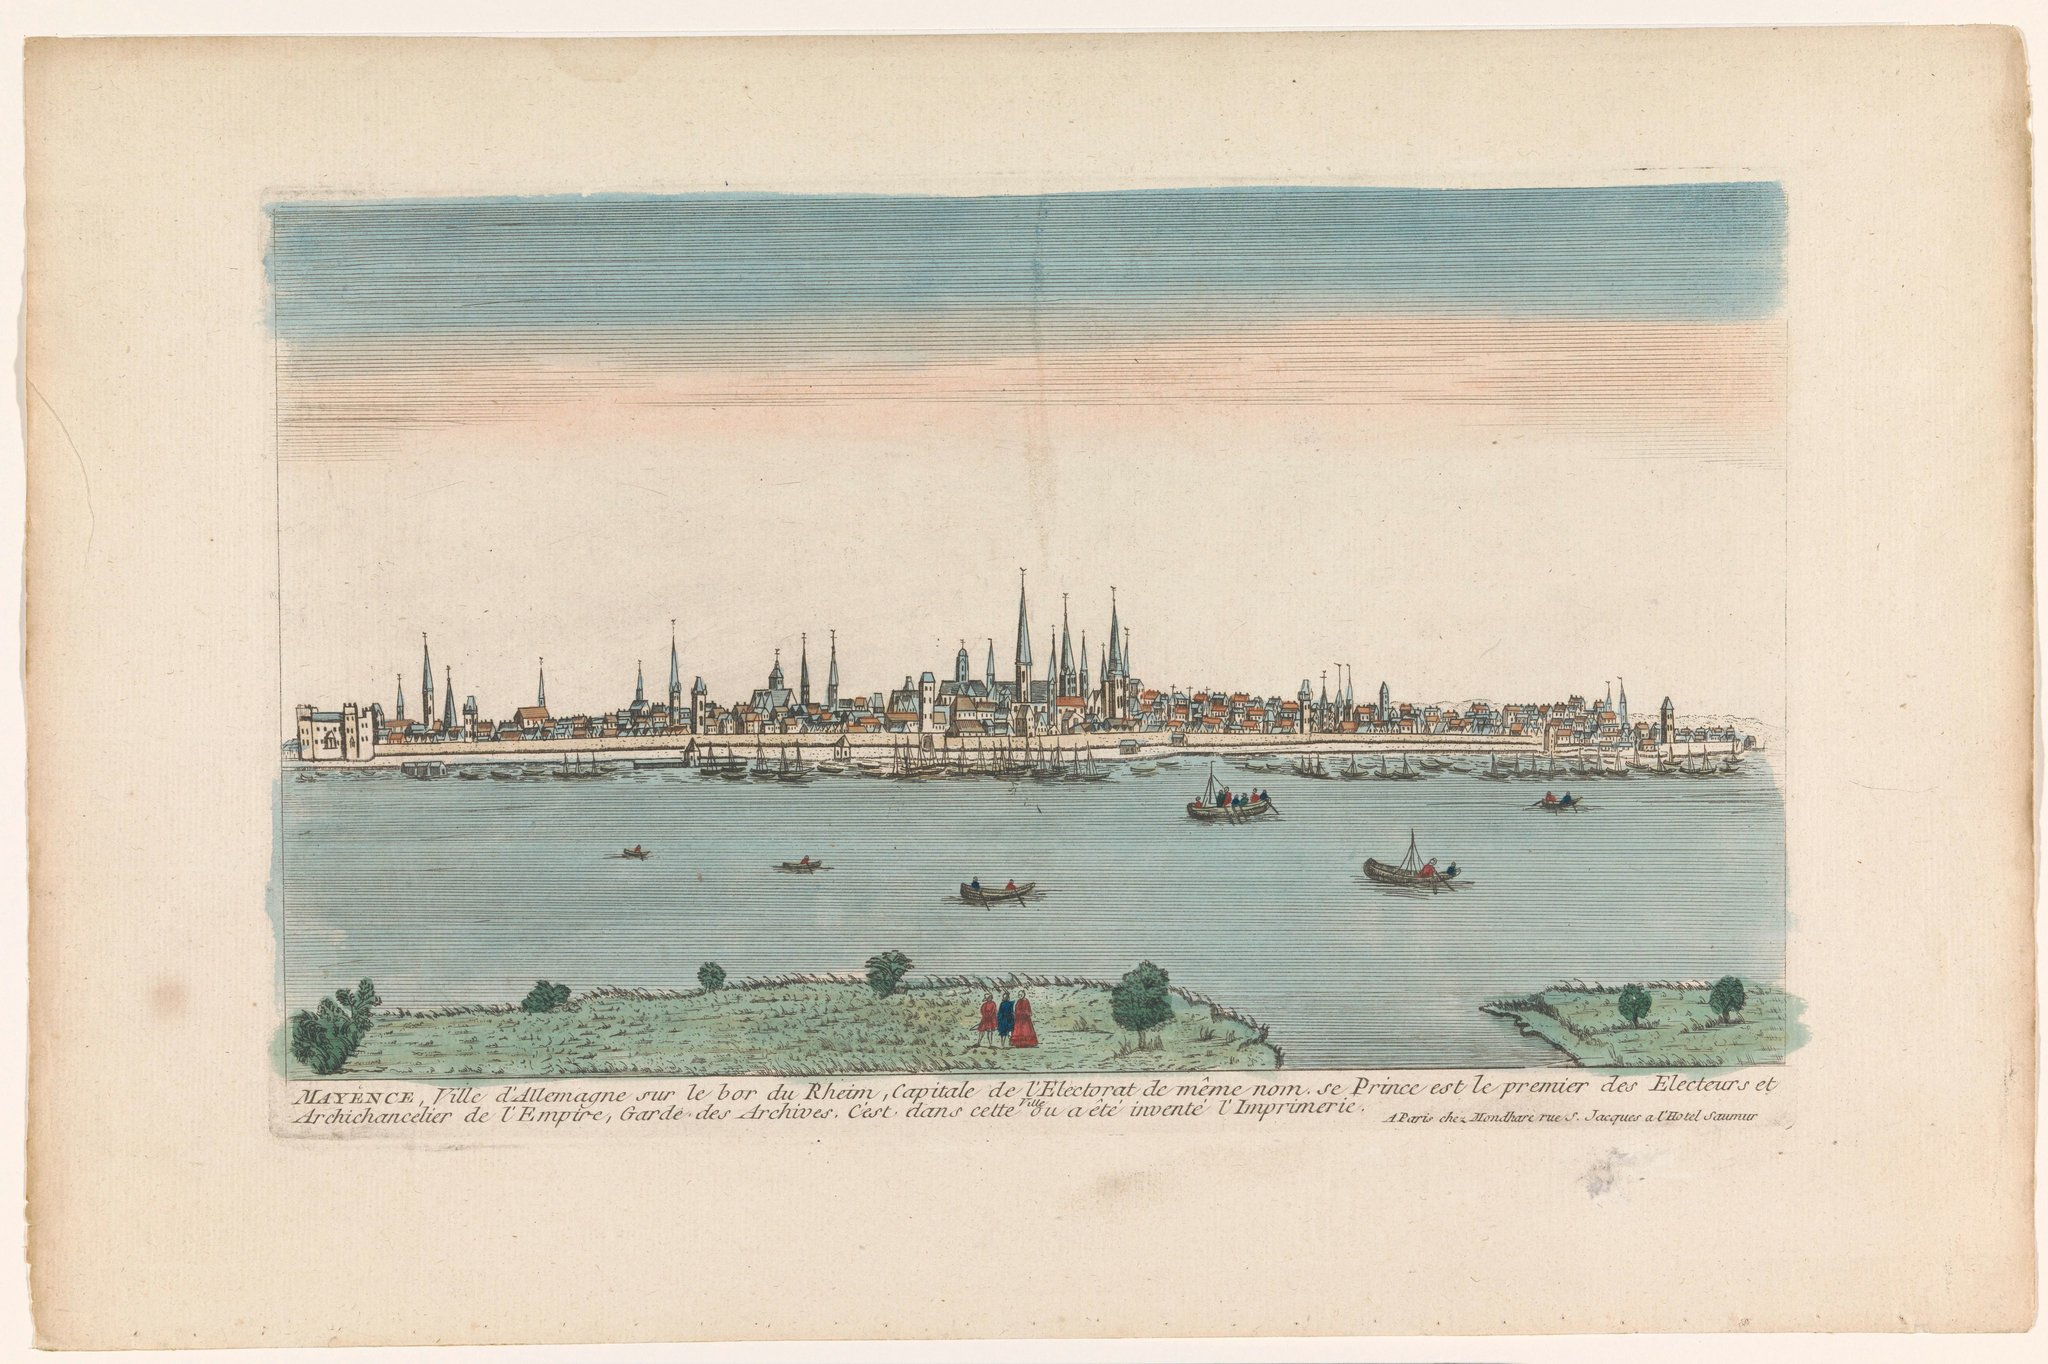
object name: print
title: Mayence, ville d'Allemagne sur le bor du Rheim ,capitale de l'electorat de même nom (...)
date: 1759-1796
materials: paper, watercolor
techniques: brush, etching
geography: paris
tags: church (exterior), rowing-boat, canoe, etc., city-view in general; 'veduta' (+ city(-scape) with figures, staffage), canals, waters (in city) (+ city(-scape) with figures, staffage)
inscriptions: watermark, collector's mark: Lugt 2166